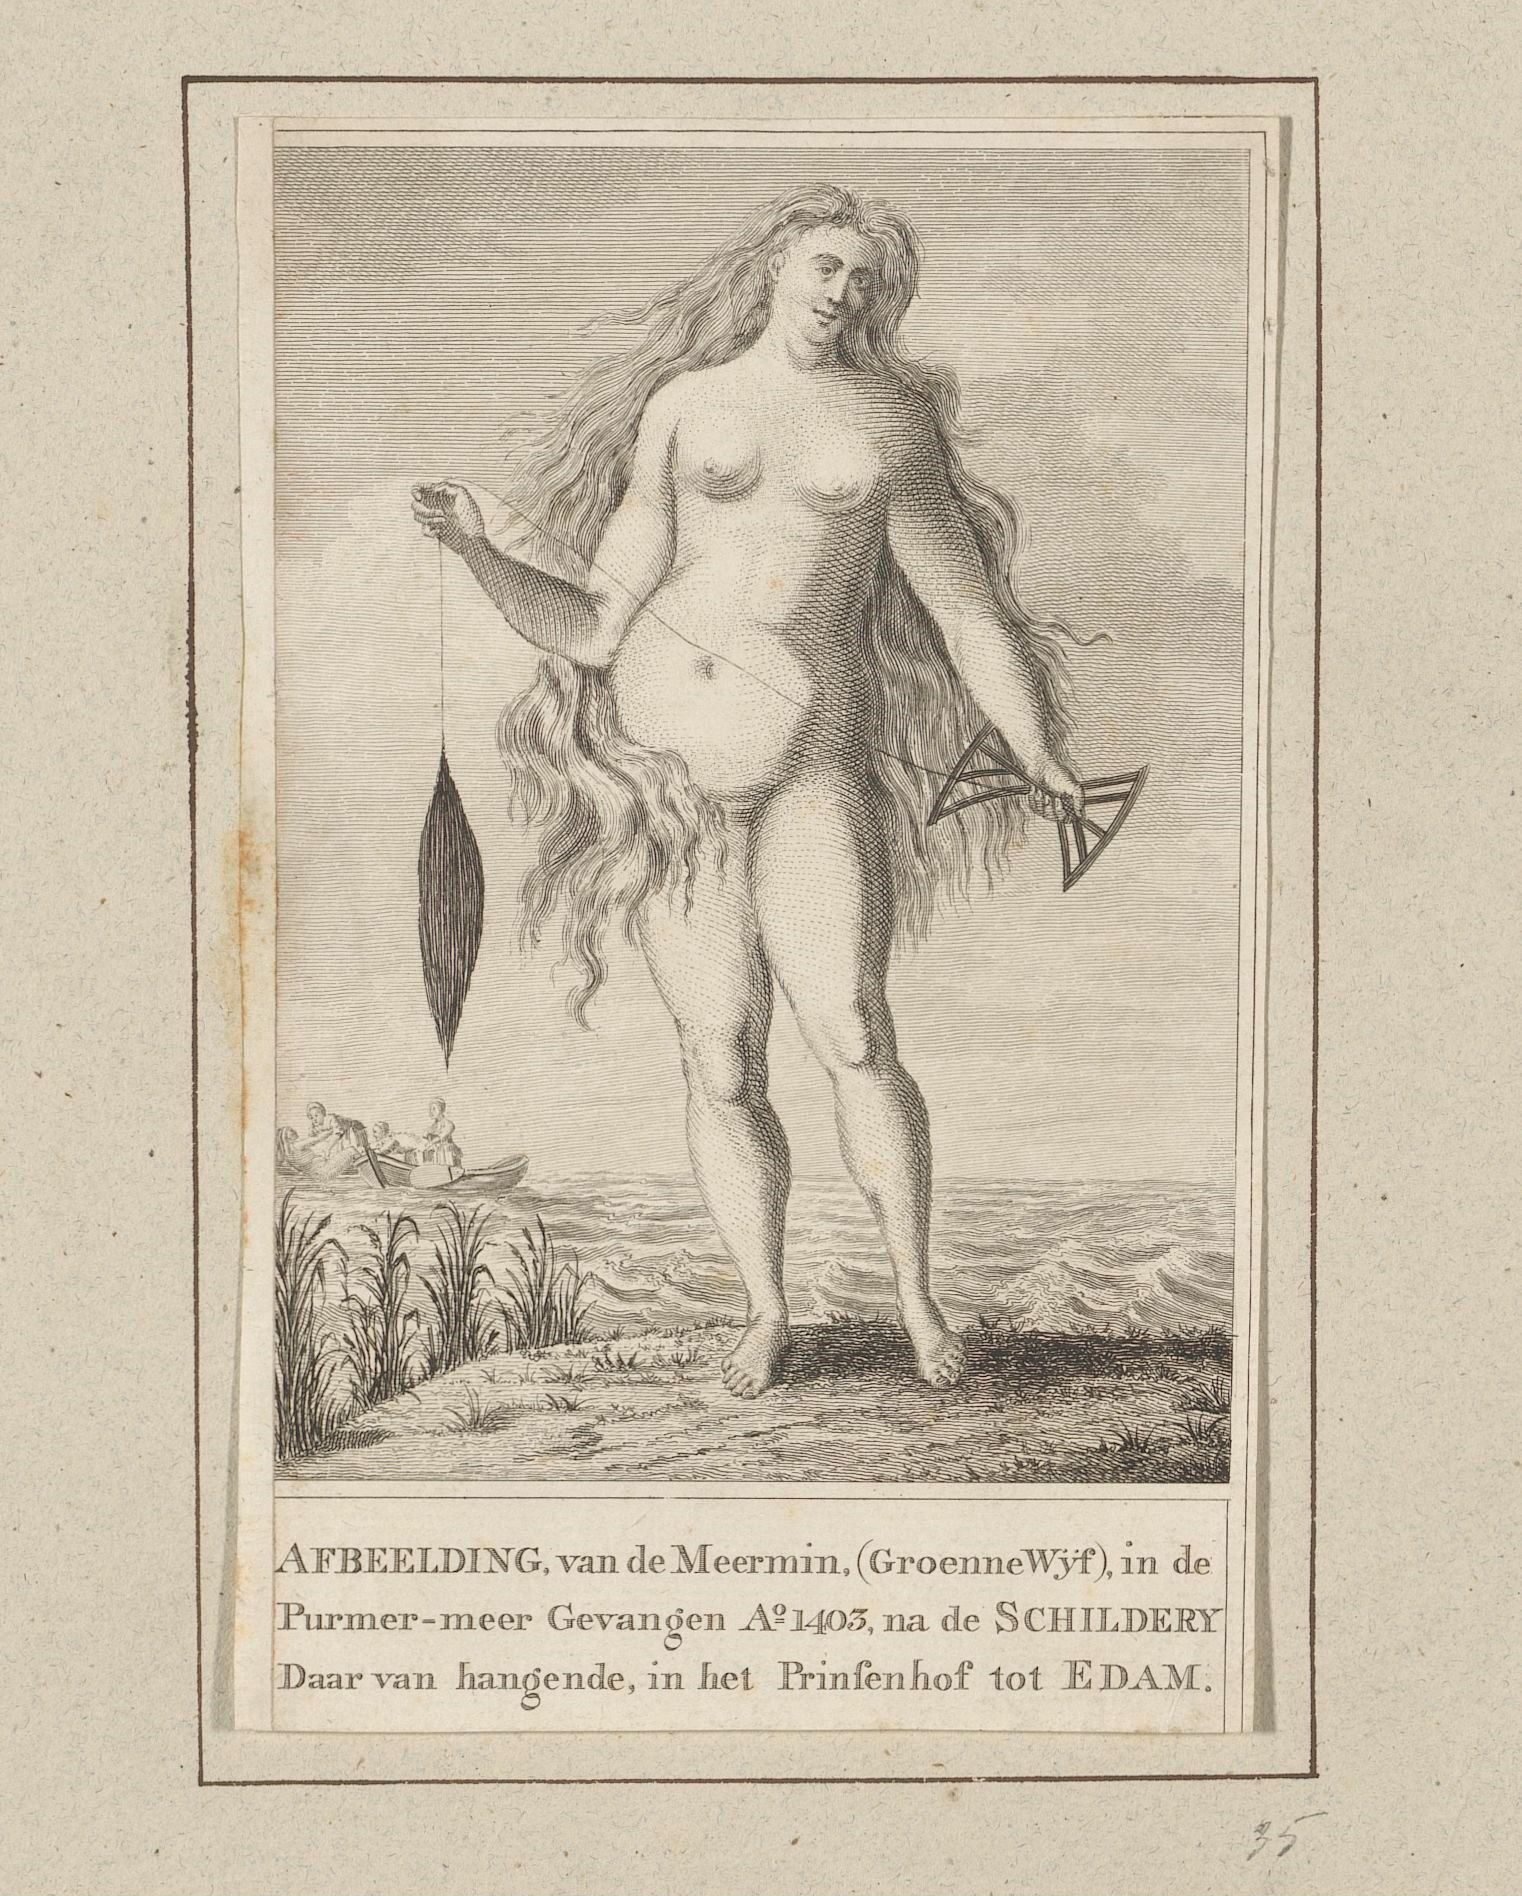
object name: print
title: Afbeelding van de Meermin, (Groenne Wijf), in de Purmer-meer gevangen A.o 1403, na de schildery daar van hangende, in het Prinsenhof tot Edam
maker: Anonymous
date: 1784-1786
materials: paper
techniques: engraving, etching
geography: northern netherlands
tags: merman, burgundian netherlands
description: Prent volgens Frederik Muller ook gebruikt in: Vosmaer, Arnout. 'Beschryving van de zoogenaamde meermin der stad Haarlem' in: Verhandelingen, uitgegeeven door de Hollandsche Maatschappye der Weetenschappen te Haarlem. Haarlem: Jan van Walré, 1786, dl. 23, plaat L. Naar een schilderij in het Prinsenhof te Edam.